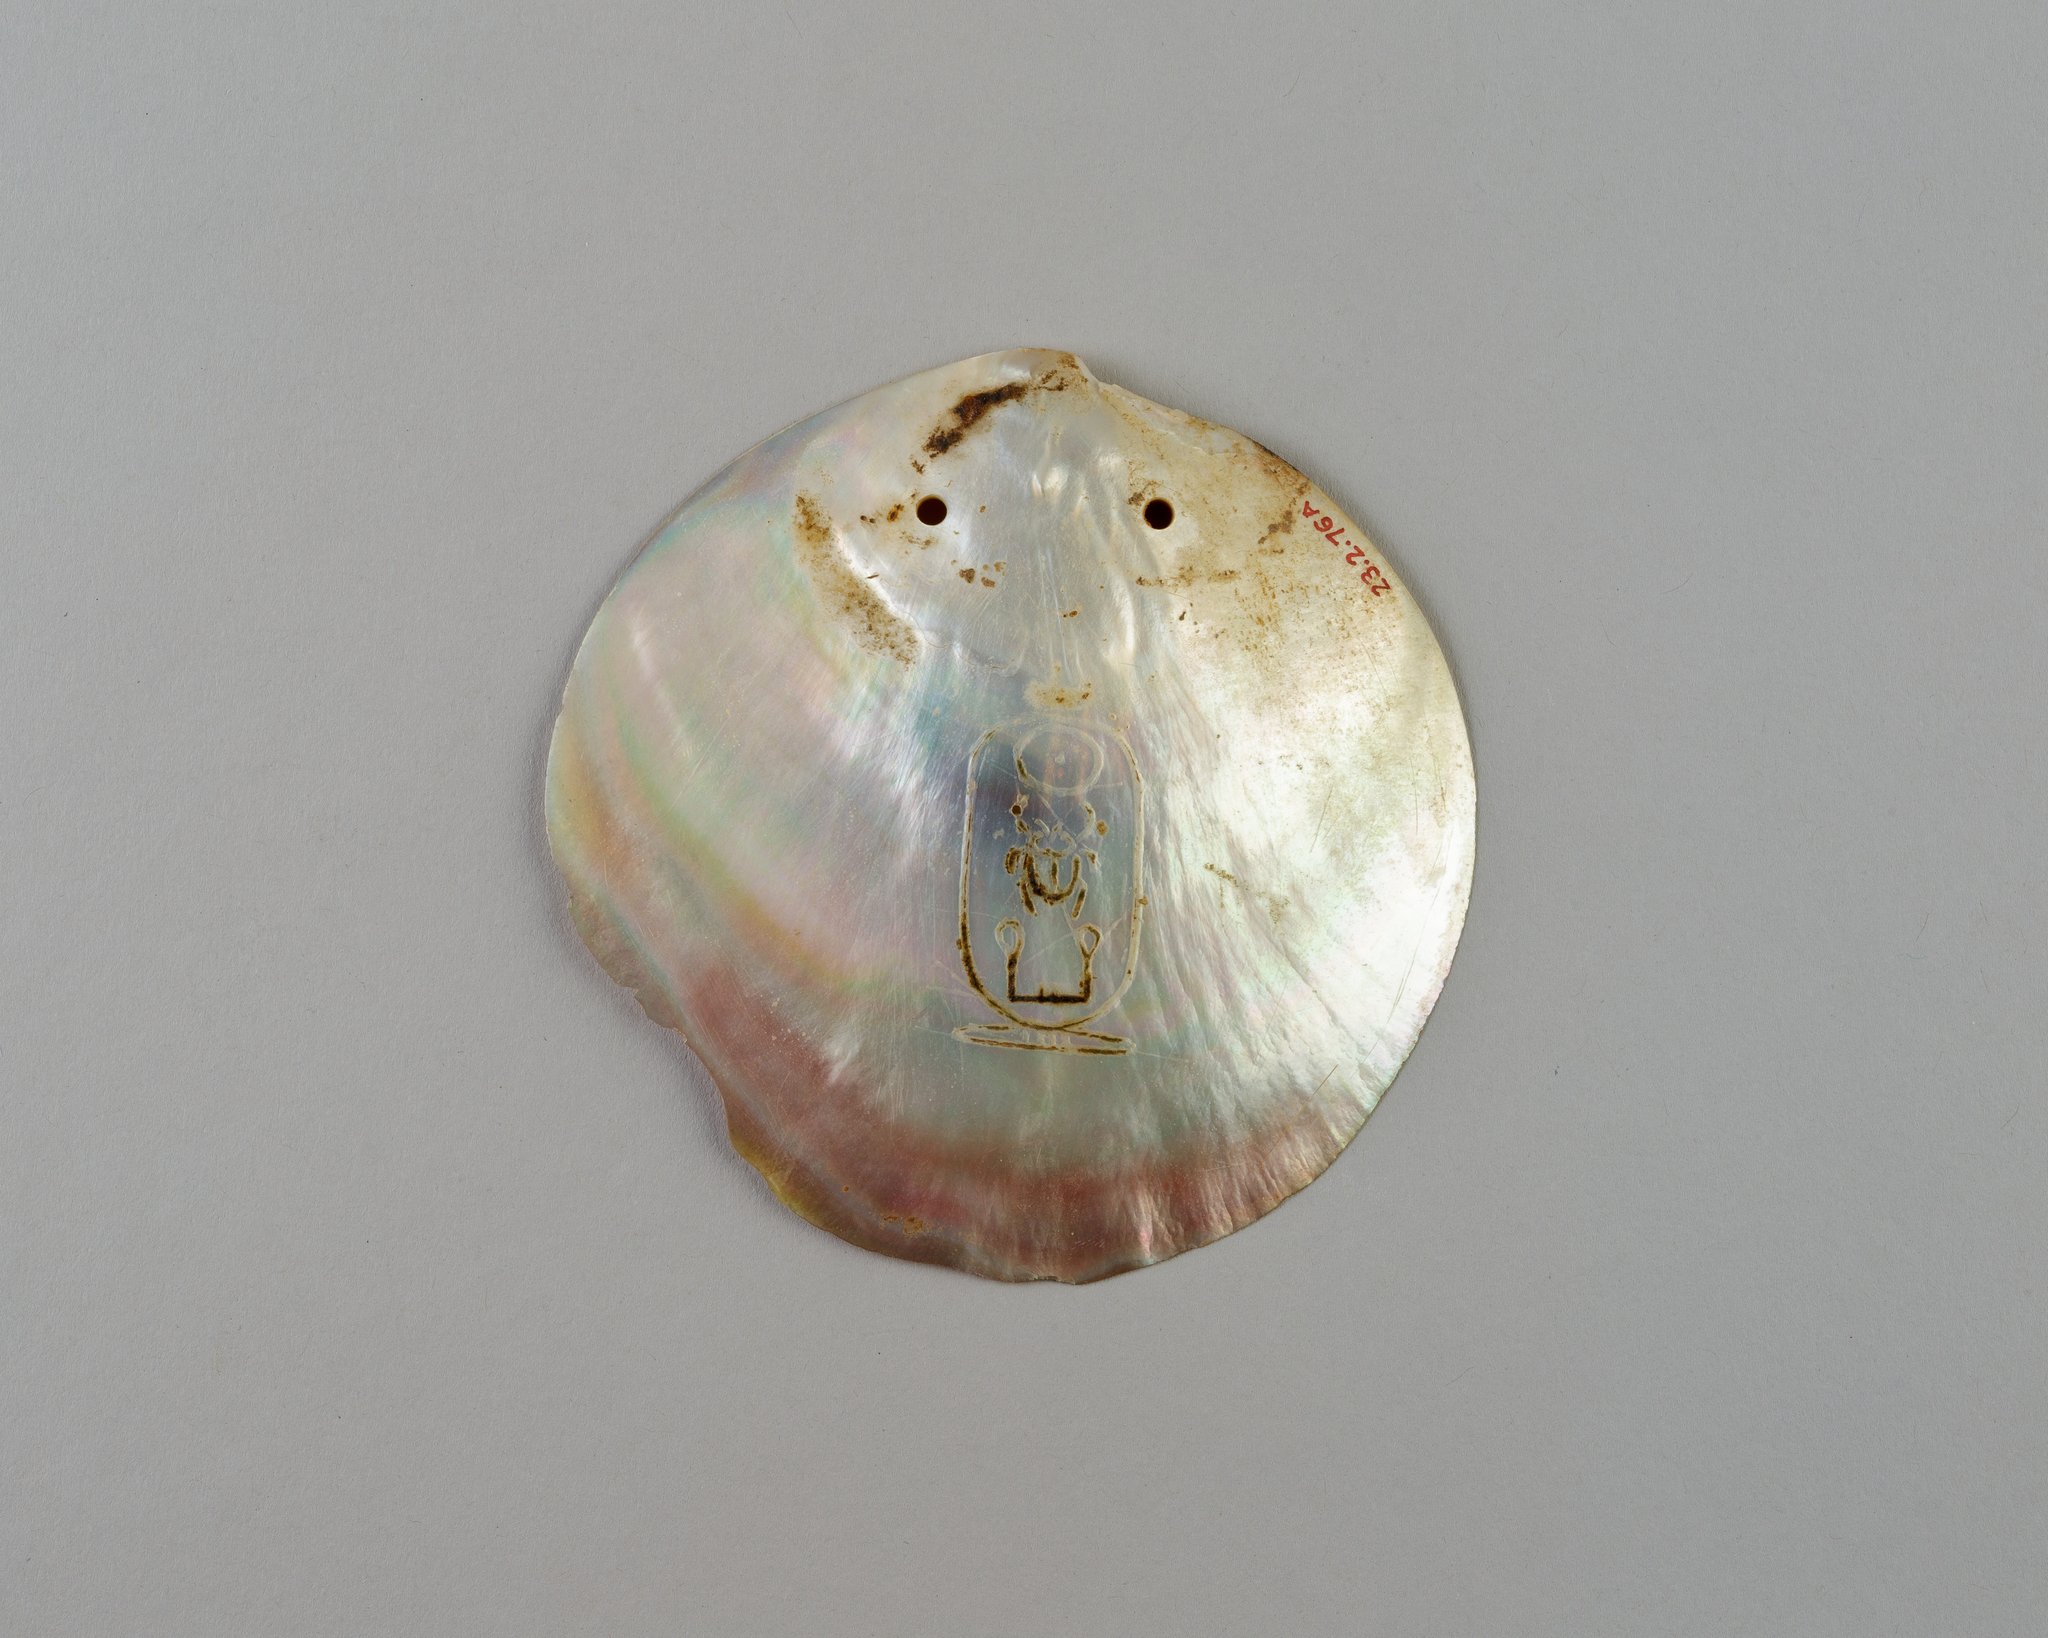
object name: shell, senwosret i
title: Shell Inscribed with the Cartouche of Senwosret I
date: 1981-1550 BCE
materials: shell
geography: southern upper egypt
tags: cartouches